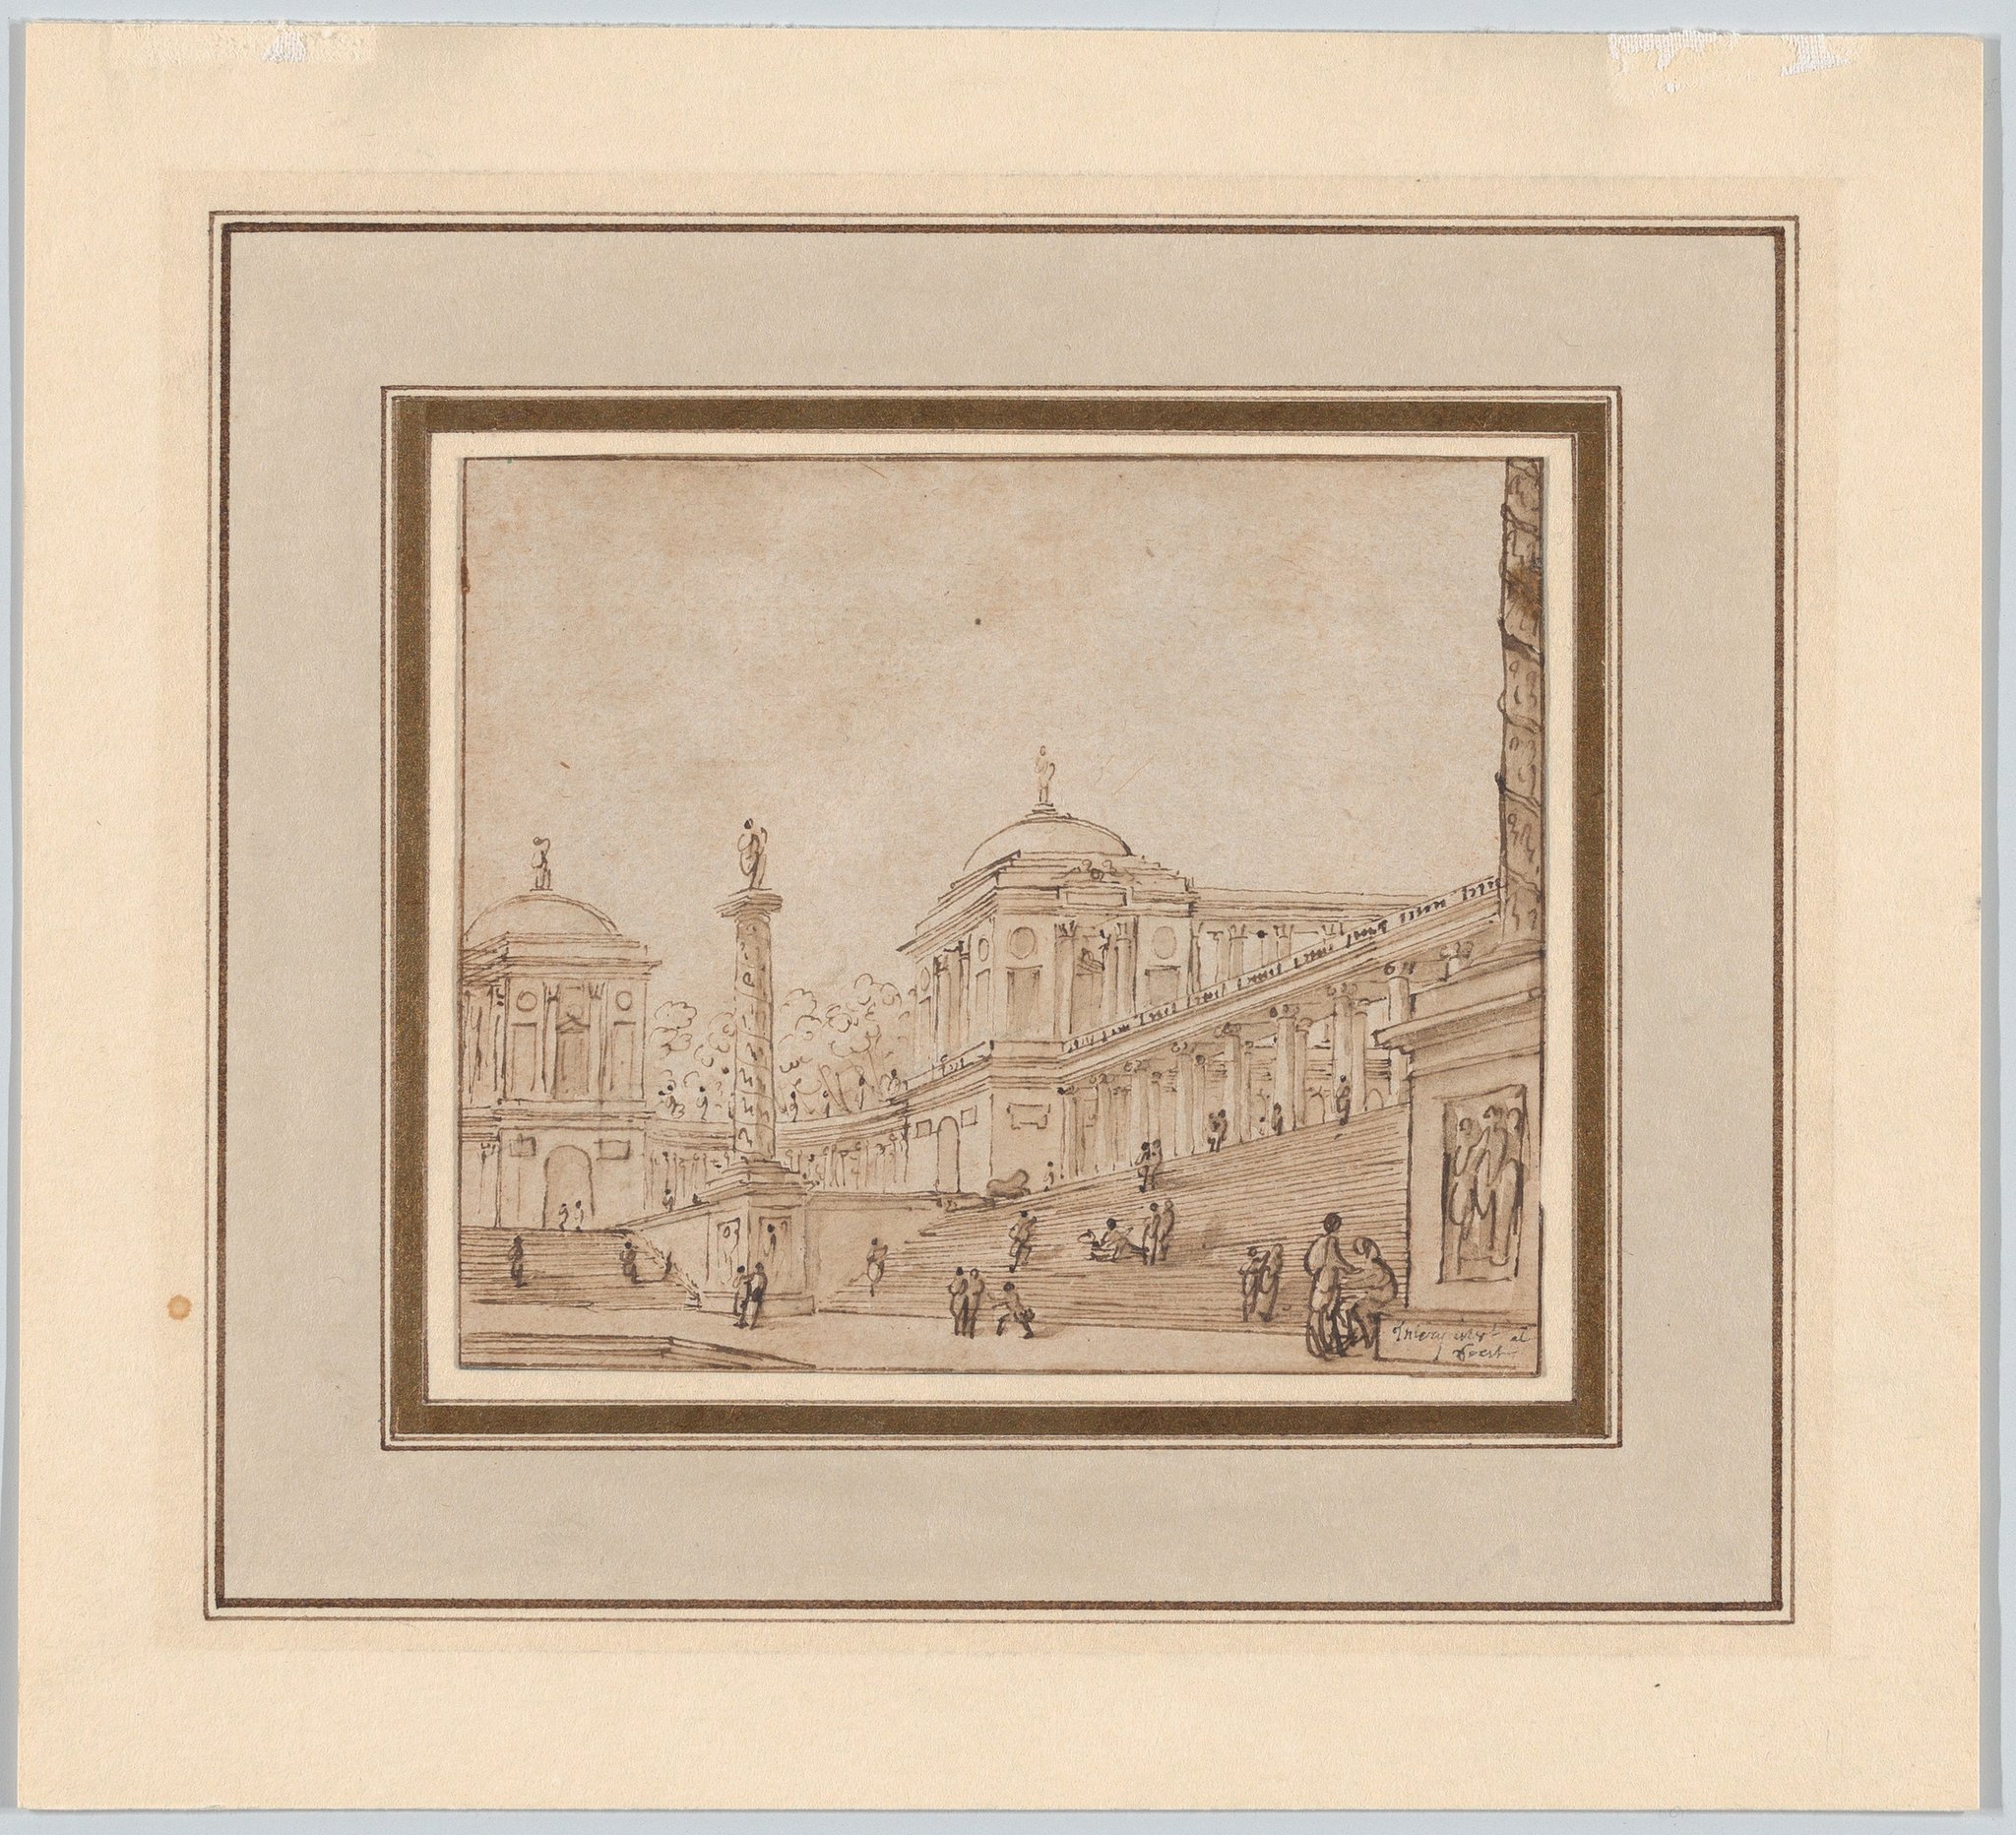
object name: drawing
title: An Architectural Capriccio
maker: luc vincent thiery de sainte colombe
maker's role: artist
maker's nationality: french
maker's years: 1734-1812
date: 1772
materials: ink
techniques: brush, pen, wash